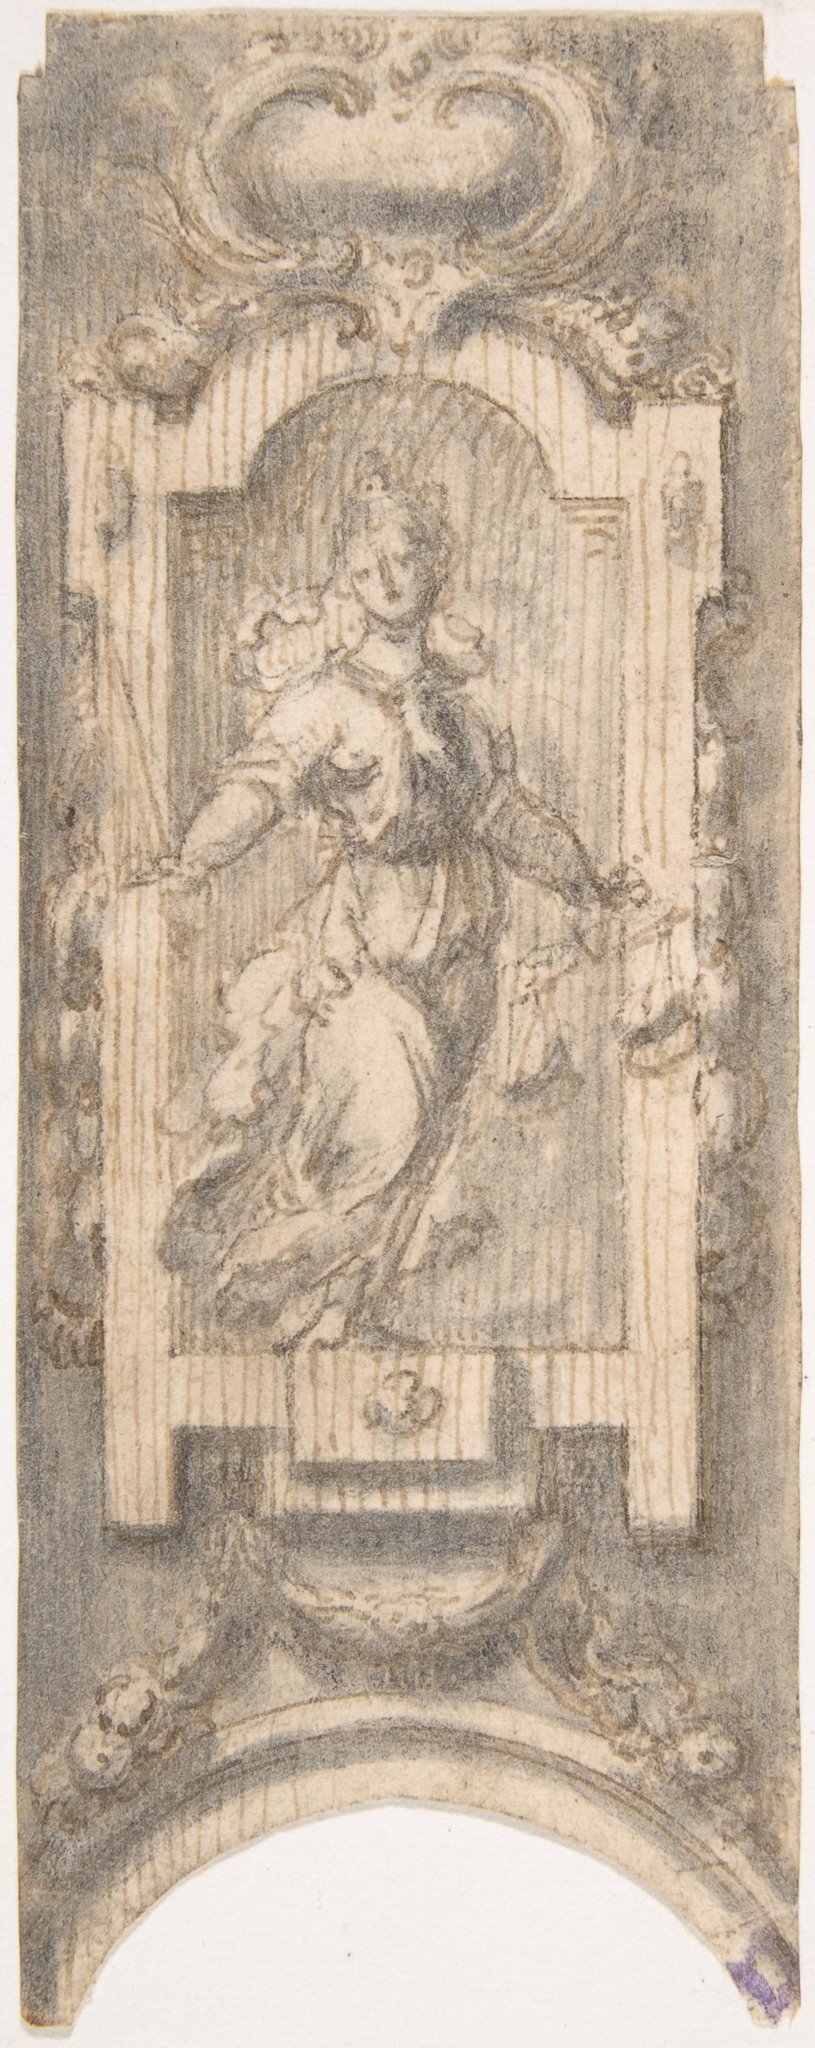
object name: drawing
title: Design for the Decoration over an Arch with the Personification of Justice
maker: anonymous, italian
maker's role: artist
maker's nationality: italian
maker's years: 1400-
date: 1680-1730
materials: chalk, ink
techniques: brush, pen, wash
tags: women